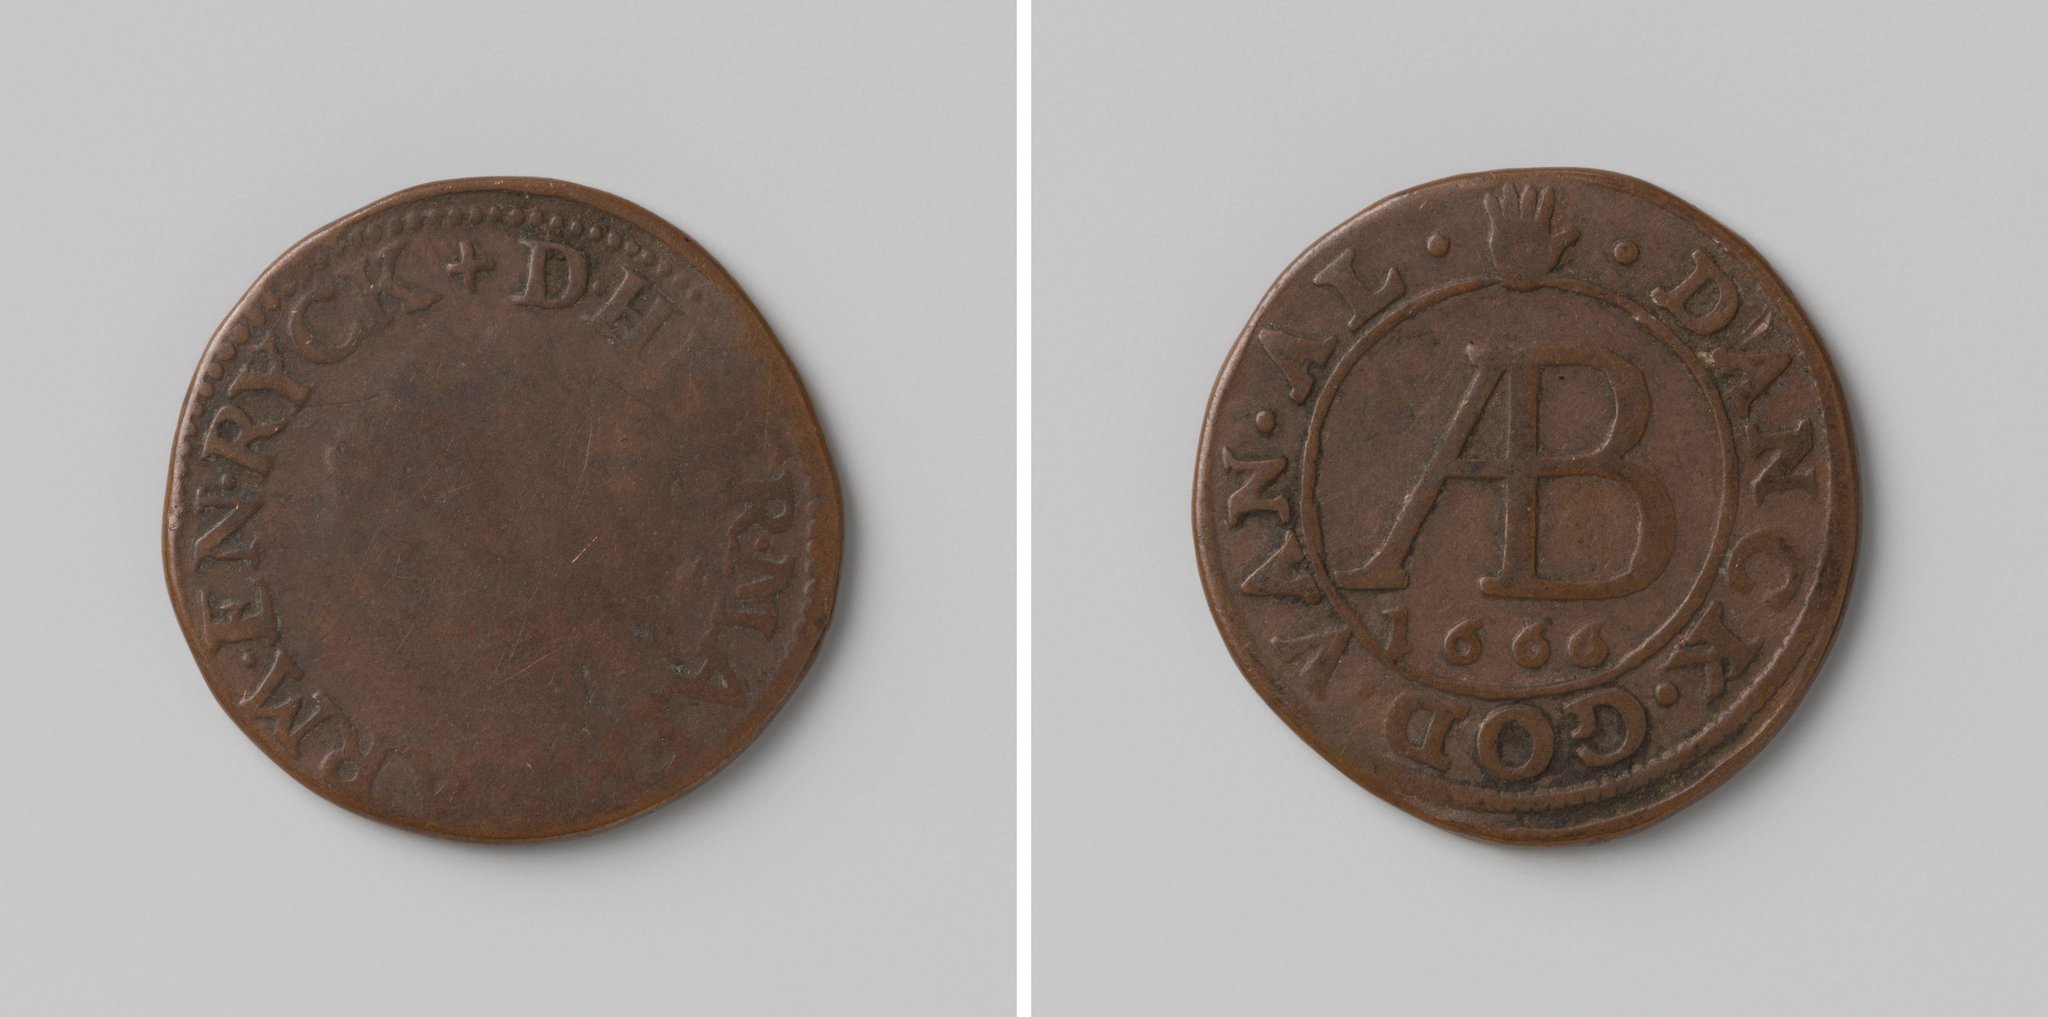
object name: armenloodje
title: Stad Antwerpen, loodje dat bij uitdeling recht gaf op brood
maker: Anonymous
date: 1666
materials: copper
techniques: striking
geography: antwerp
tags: antwerp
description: Koperen penning. Voorzijde: twee geopende handen boven burcht binnen omschrift. Keerzijde: monogram van letters A en B boven jaartal binnen omschrift